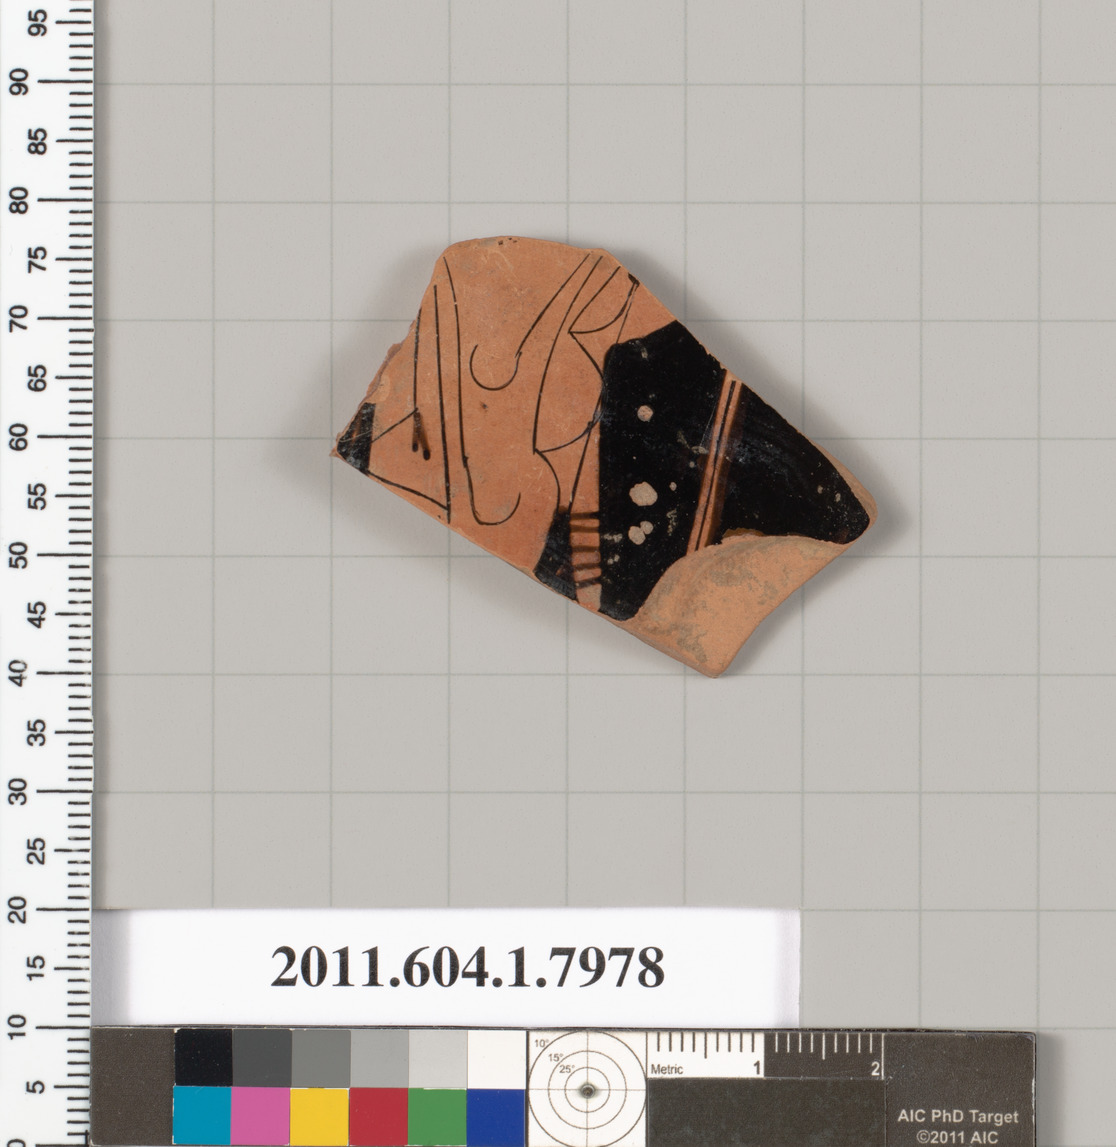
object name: kylix fragment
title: Terracotta fragment of a kylix (drinking cup)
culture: greek, attic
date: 460-450 BCE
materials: terracotta